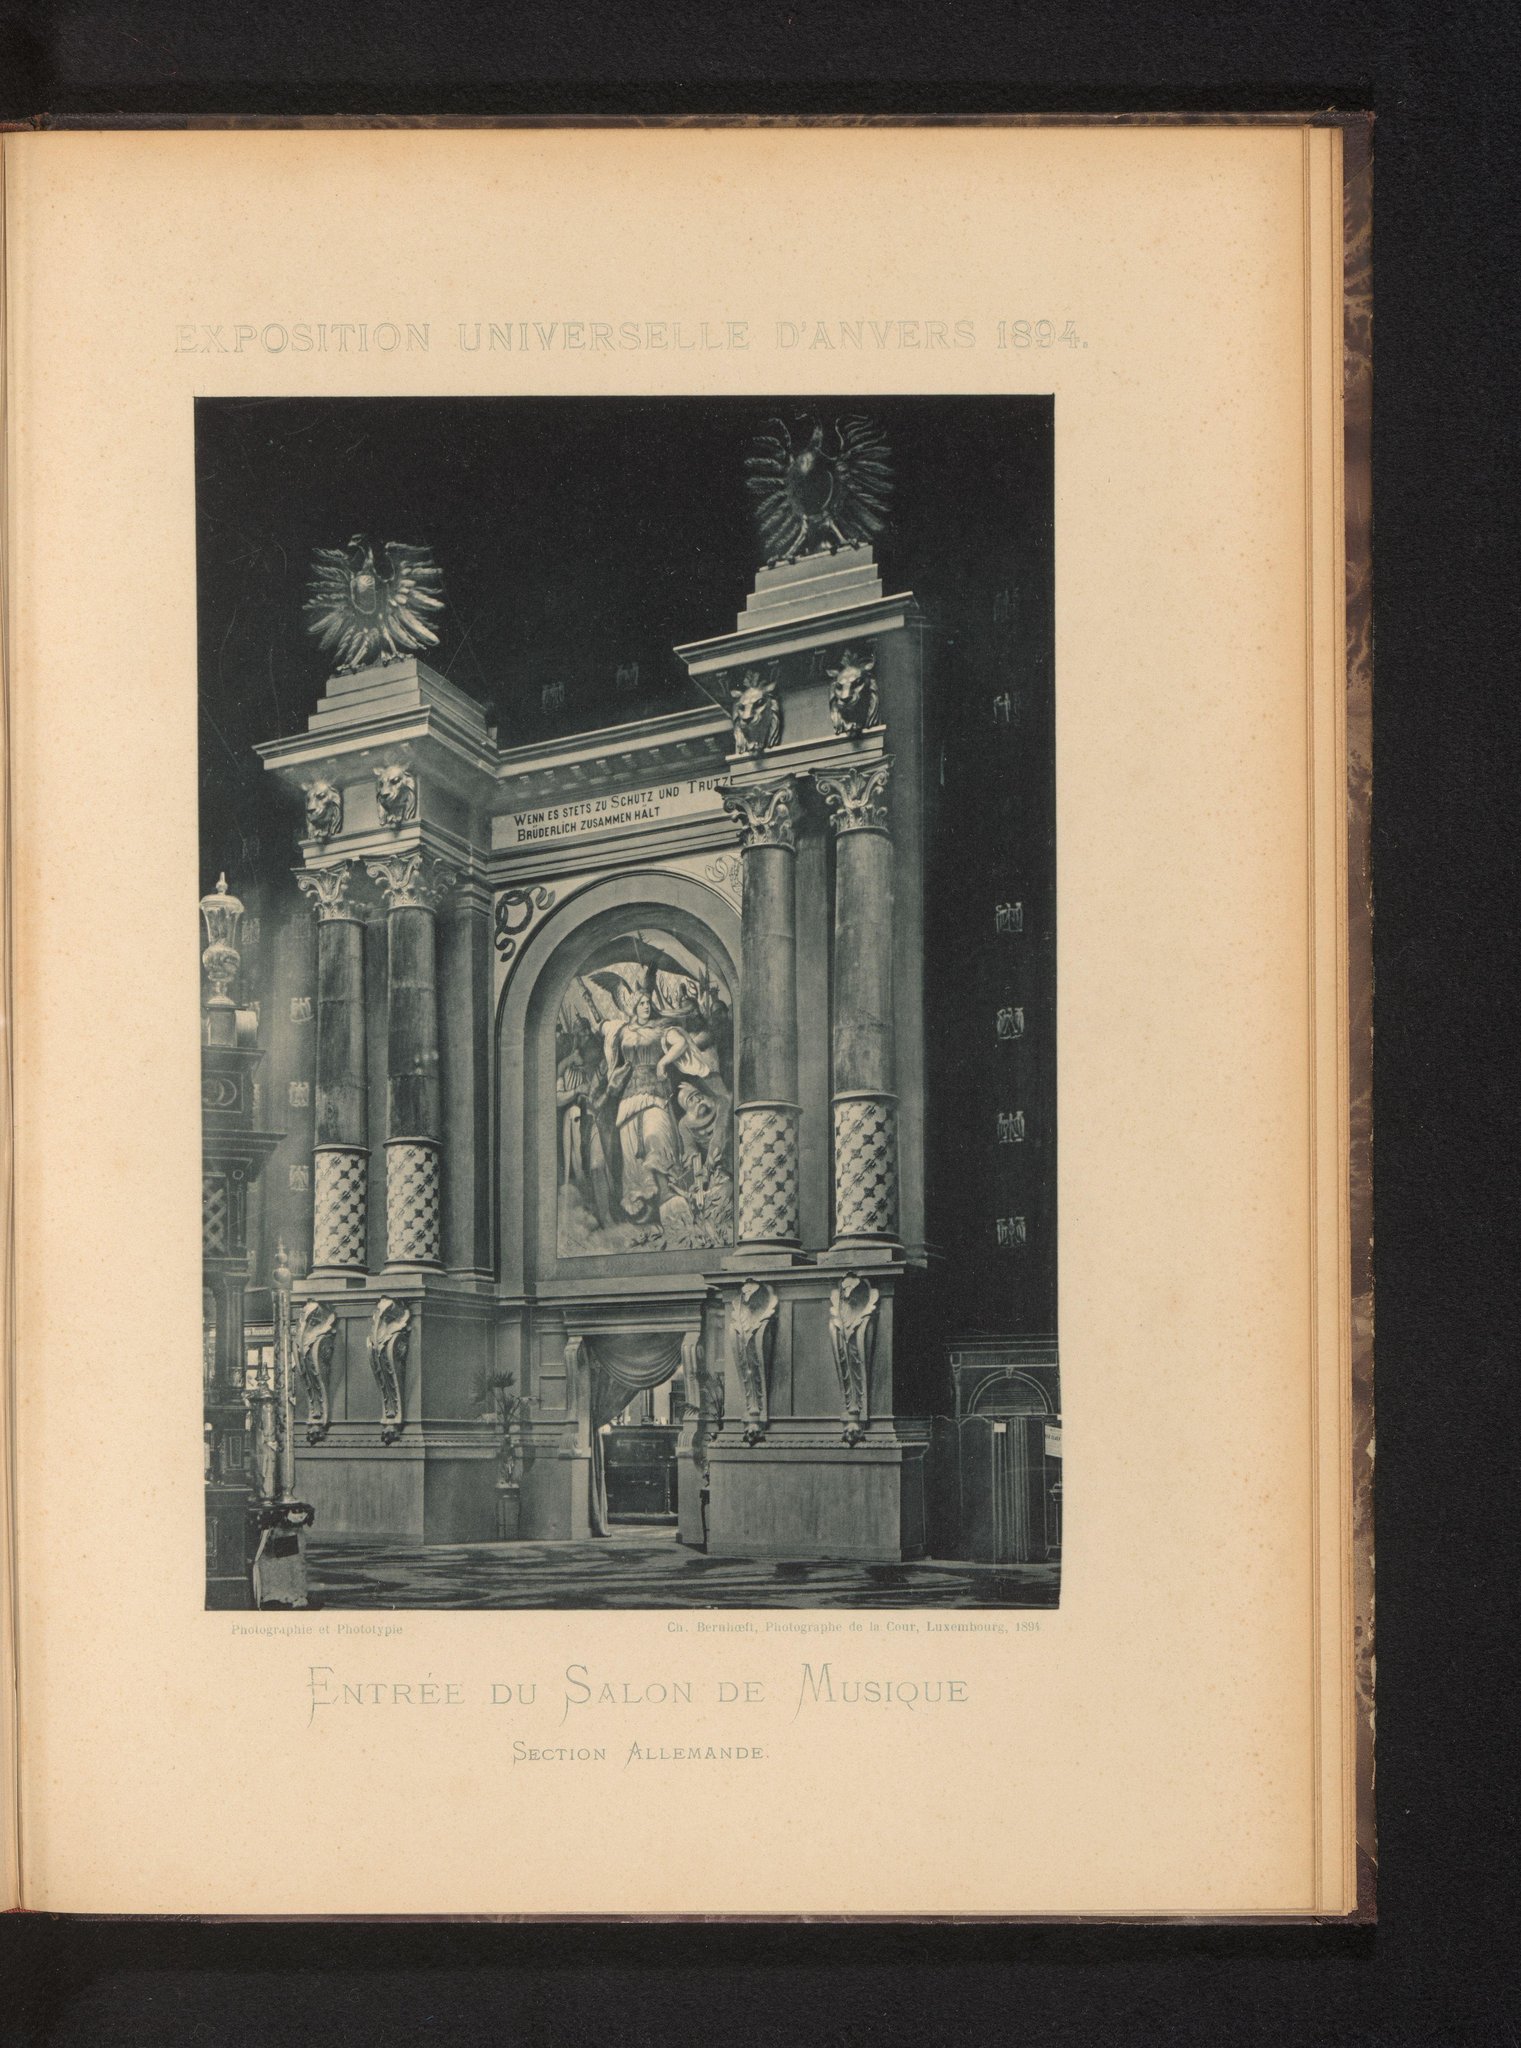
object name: page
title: Gezicht op de ingang van een muziekzaal in het Duitse deel van de Wereldtentoonstelling van Antwerpen in 1894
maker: charles bernhoeft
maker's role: publisher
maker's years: 1859-1933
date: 1894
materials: paper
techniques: photograph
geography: luxembourg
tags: music-hall, world fair, world exhibition, gate, entrance, antwerp